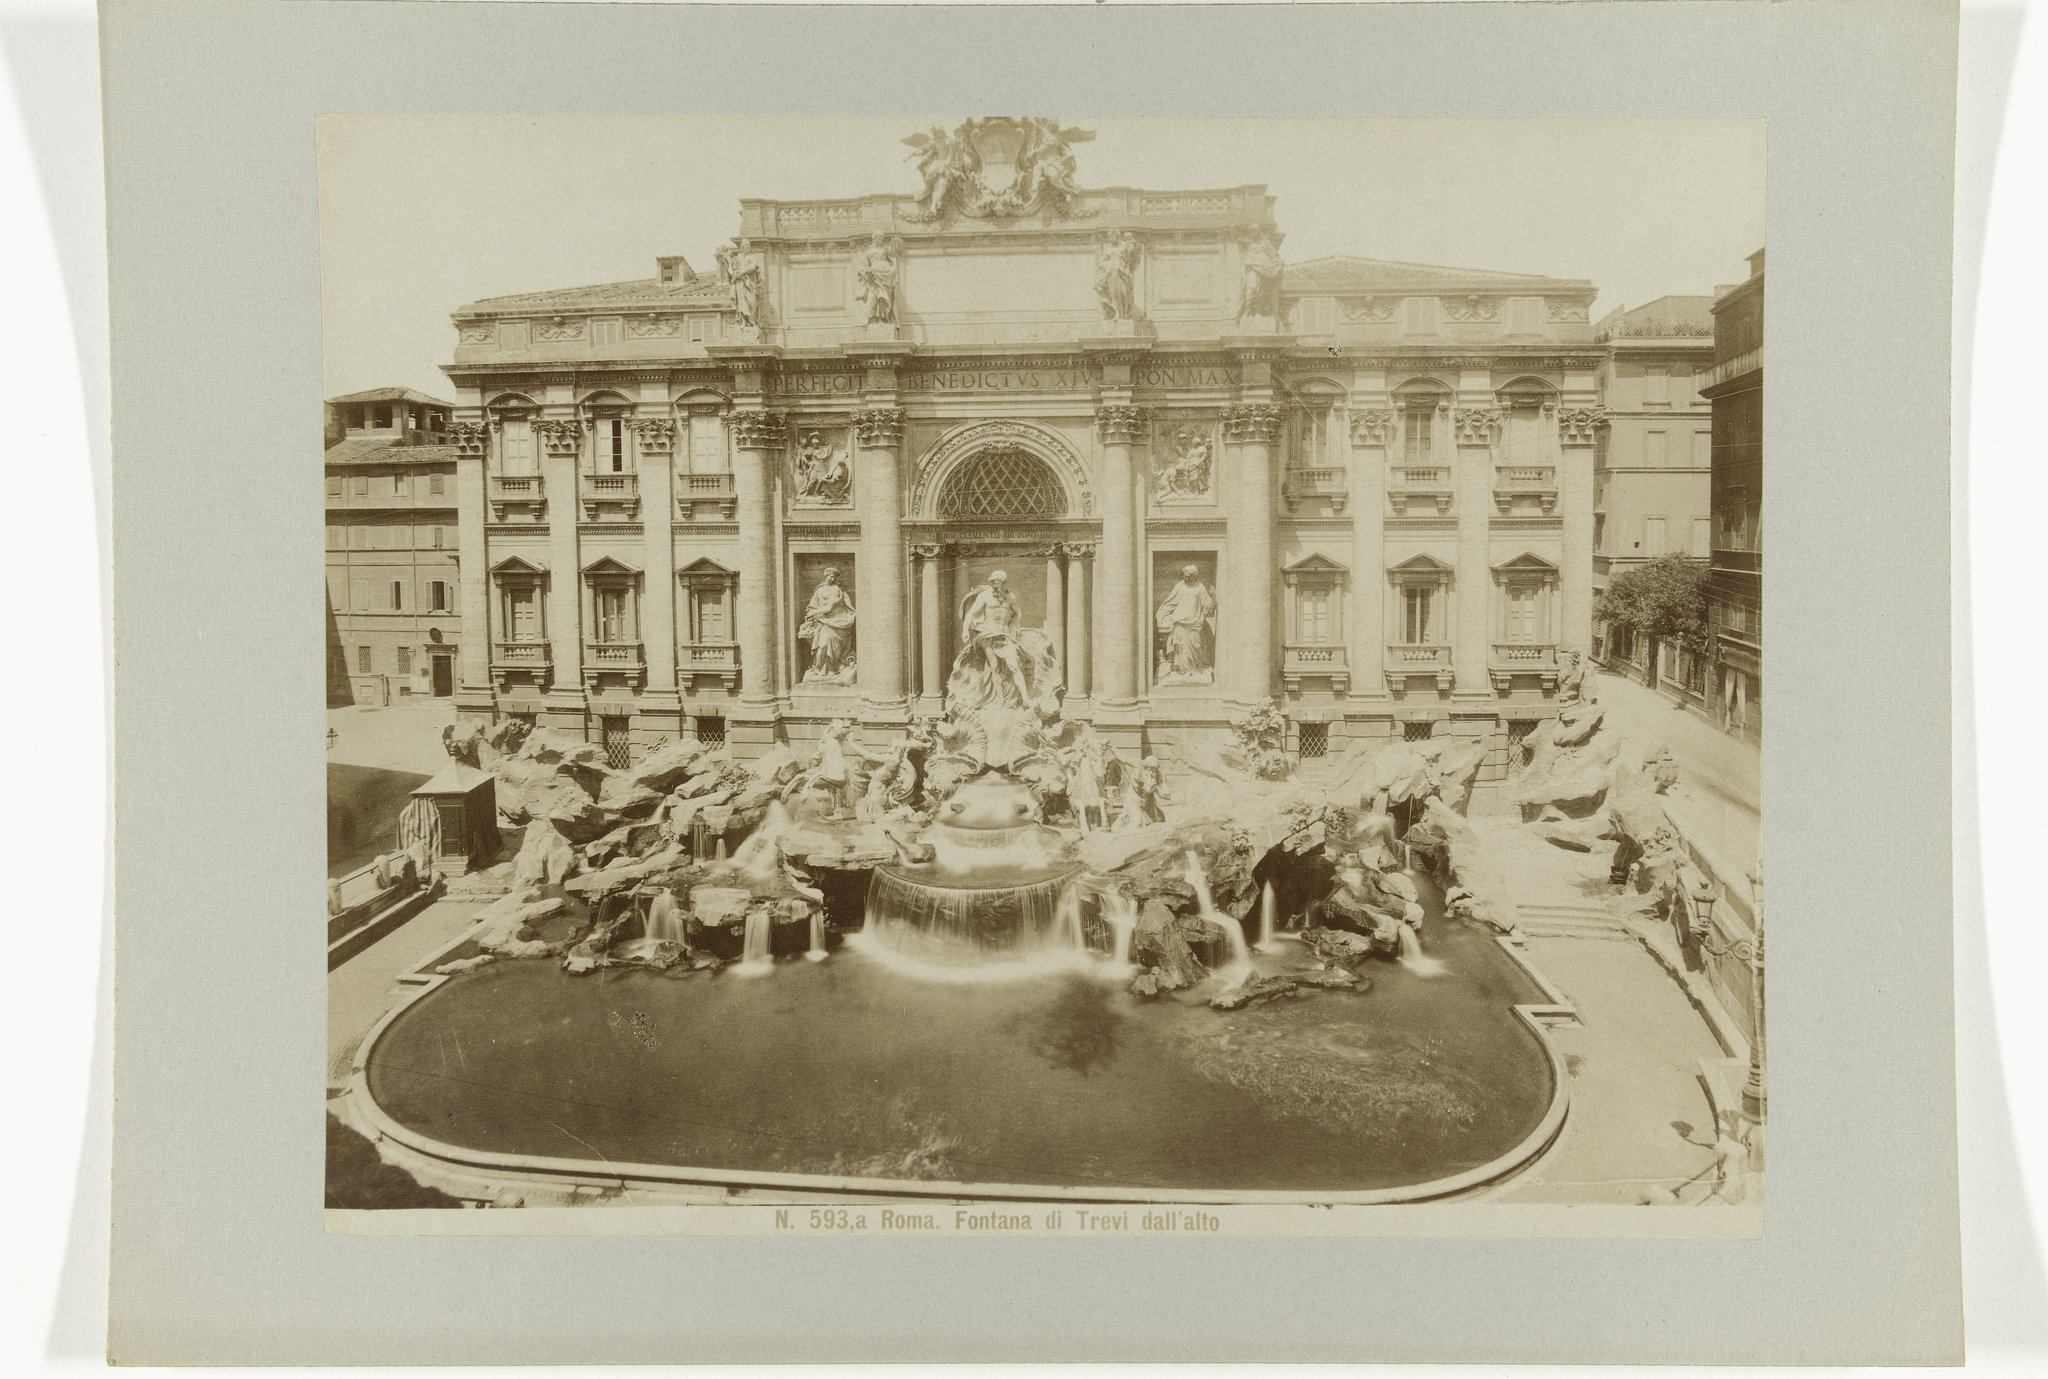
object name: photograph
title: Trevi-fontein te Rome van boven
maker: Anonymous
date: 1880-1904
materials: cardboard, paper, photographic support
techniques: albumen print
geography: rome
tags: trevifontein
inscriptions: number: ‘29.’